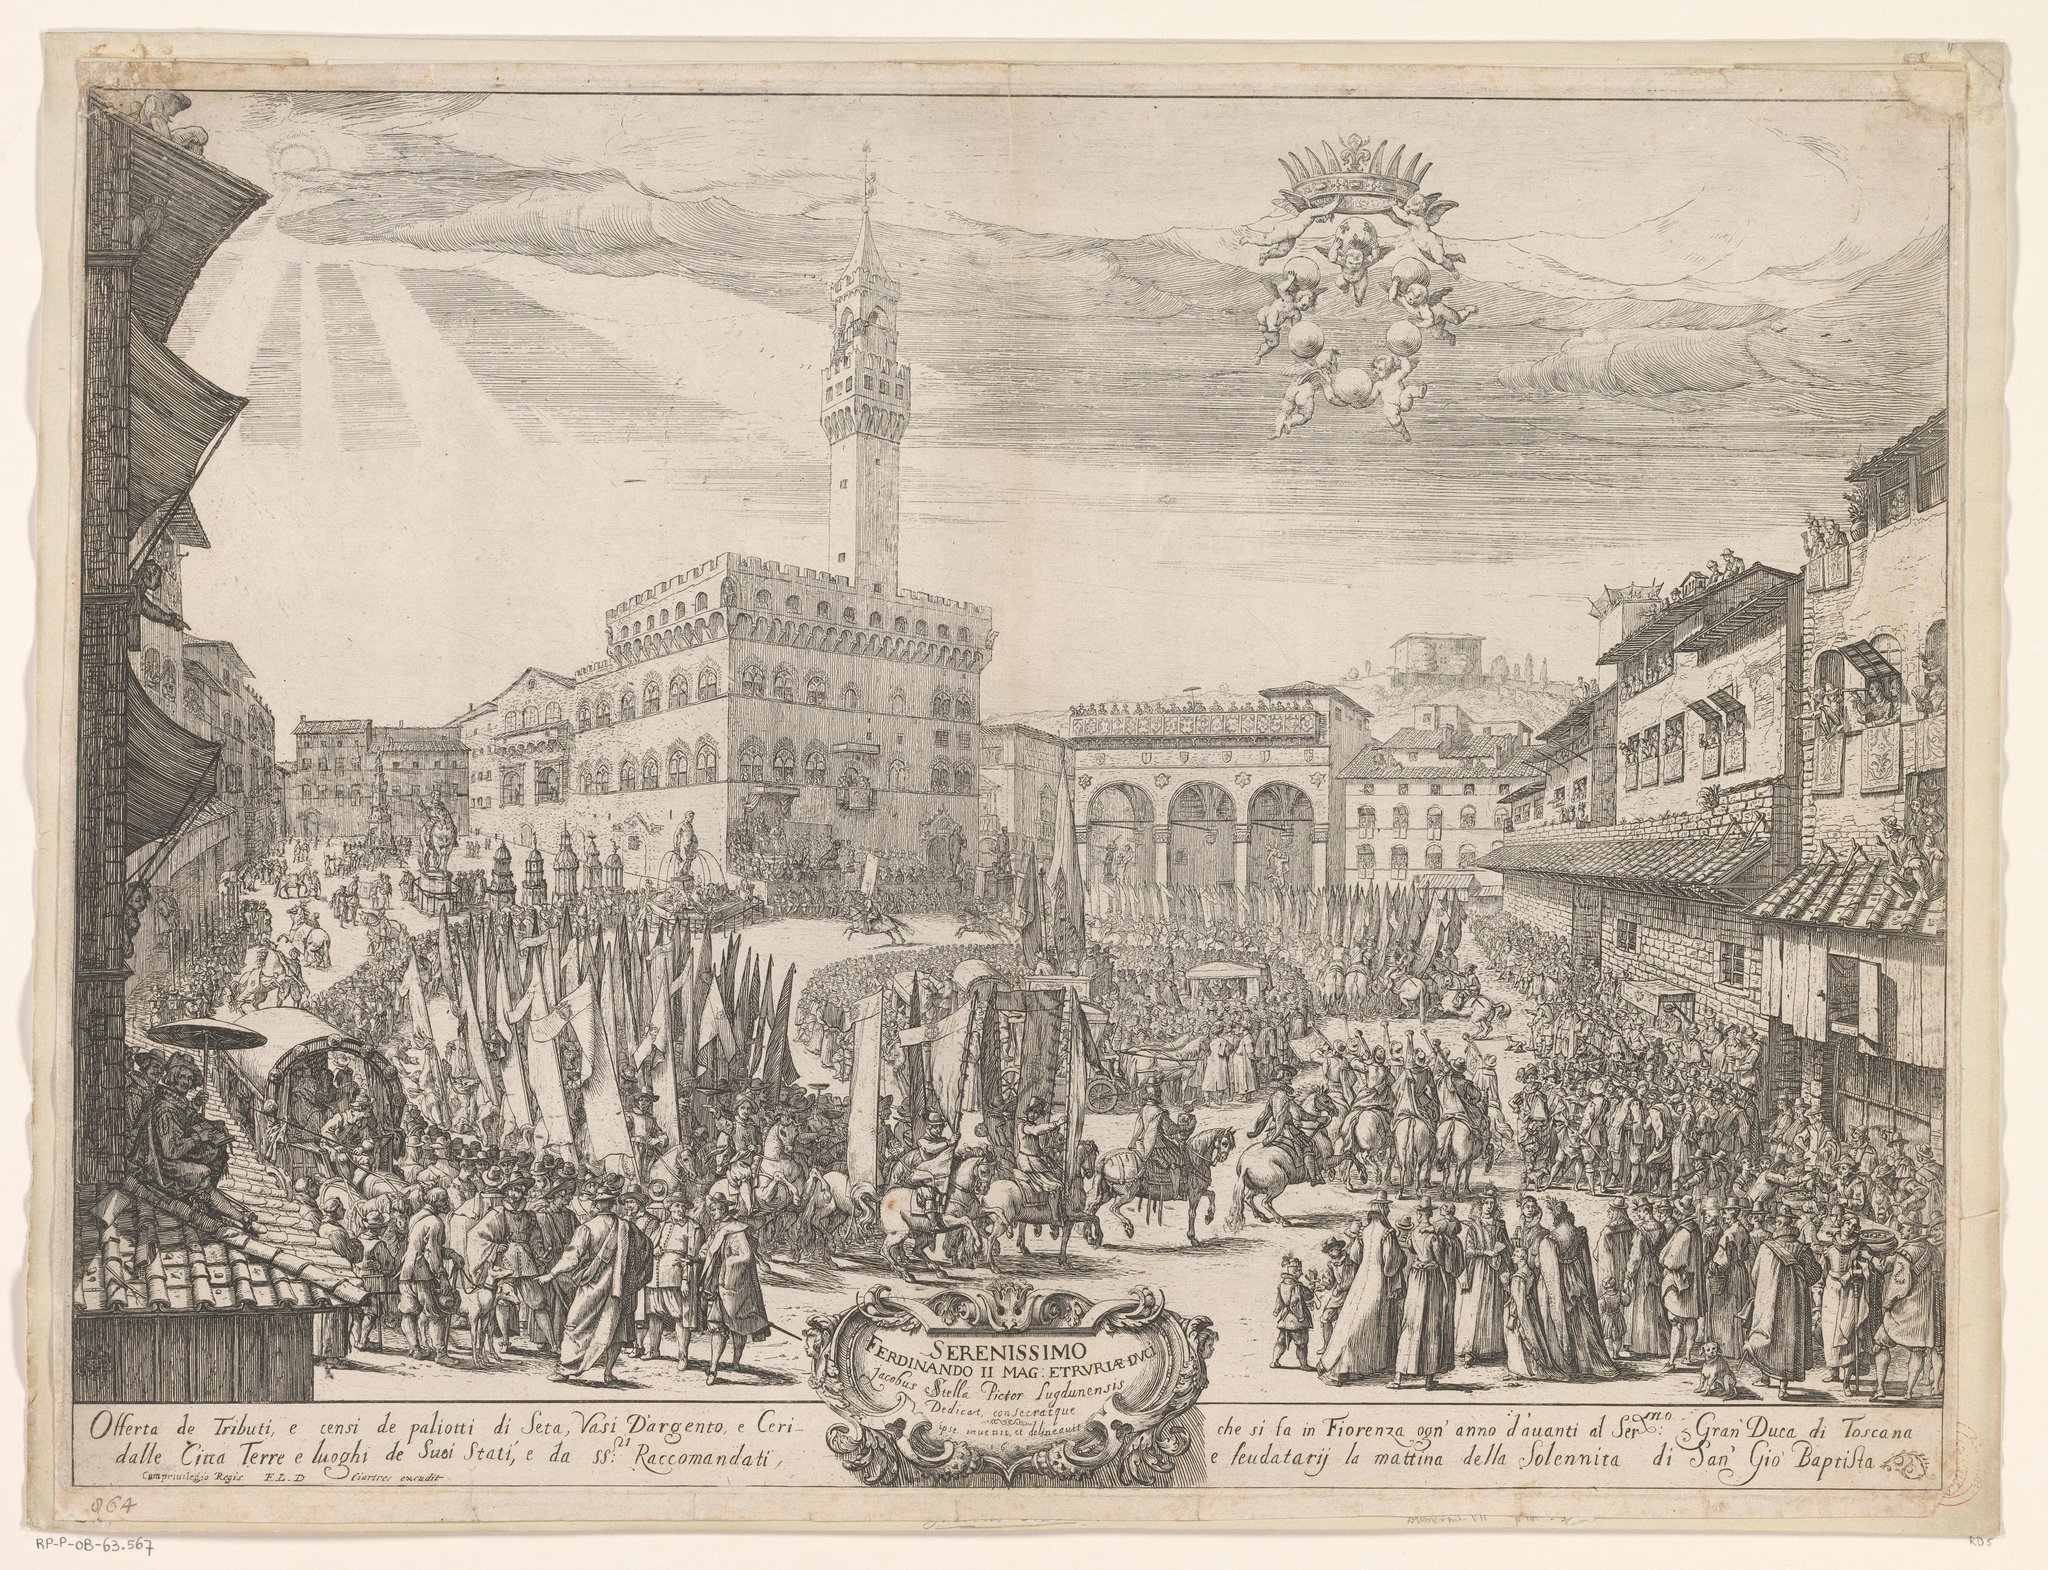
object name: print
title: Ceremonie van eerbetoon aan de groothertog van Toscane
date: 1606-1657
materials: paper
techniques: etching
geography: france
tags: paying tribute to a ruler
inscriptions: collector's mark: Lugt 240